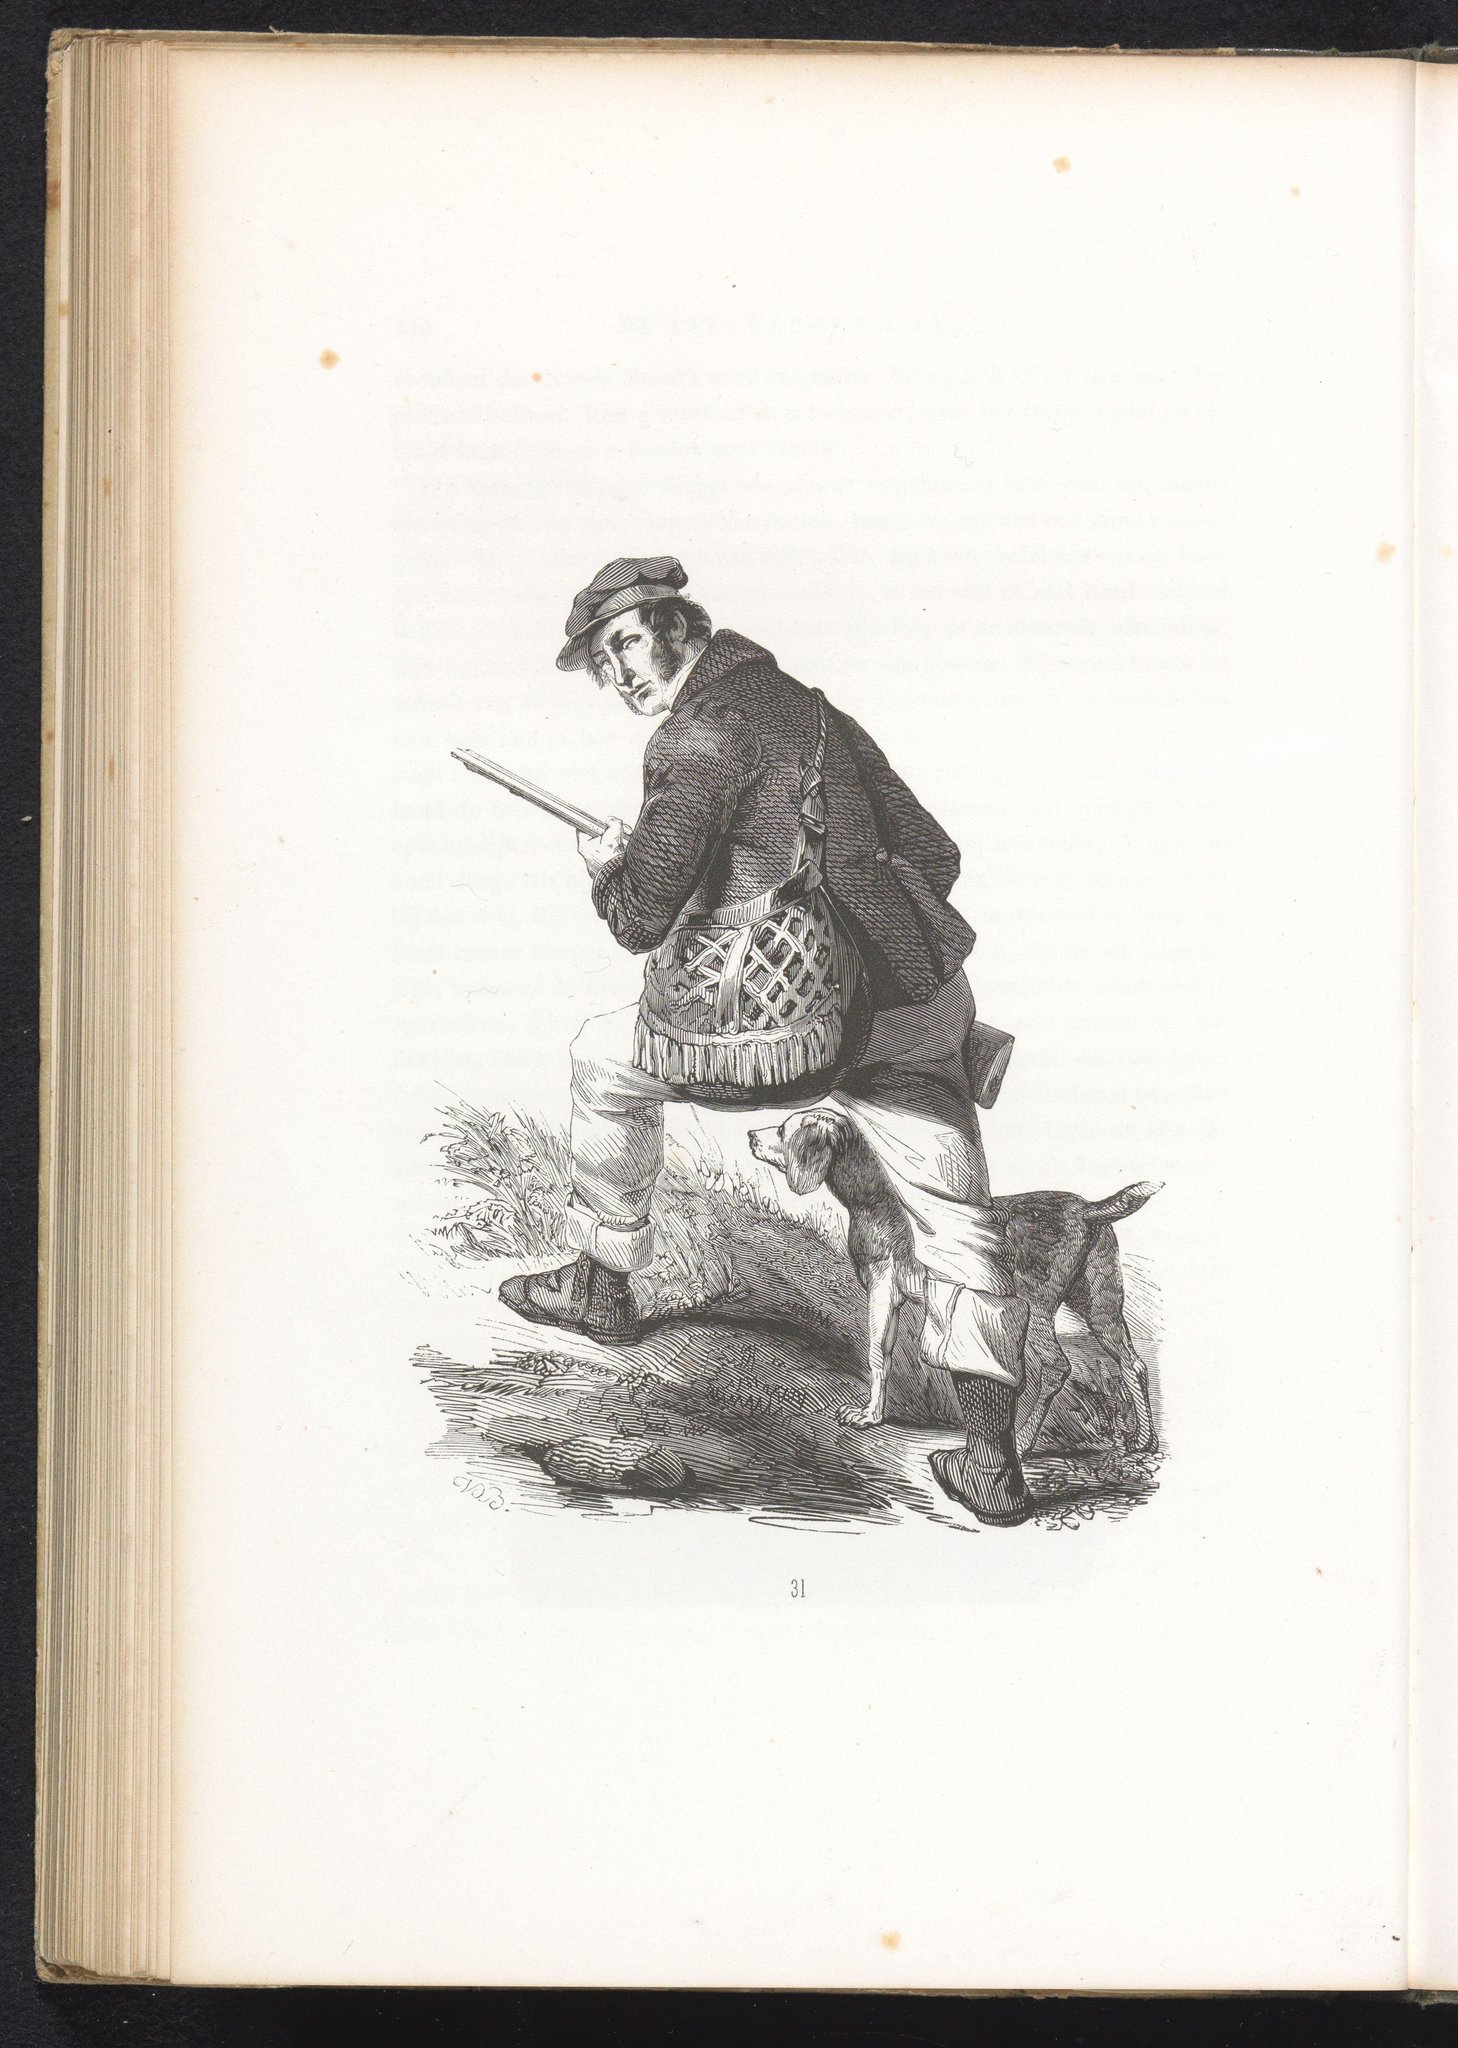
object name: print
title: De jager en de polsdrager, 1840-1841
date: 1841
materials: paper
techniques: letterpress printing, engraving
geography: the hague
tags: professional clothes, hunters hunting (n.b.: in 1988-1990 this notation denoted the concept of 43c11421 'hunters resting during the hunt'), netherlands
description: Een jager met een weitas en jachthond. Genummerd: 31. Illustratie in het boek 'De Nederlanden: karakterschetsen, kleederdrachten, houding en voorkomen van verschillende standen', een boek met karakterschetsen, beroepen en klederdrachten van Nederlandse volkstypen uit 1841.